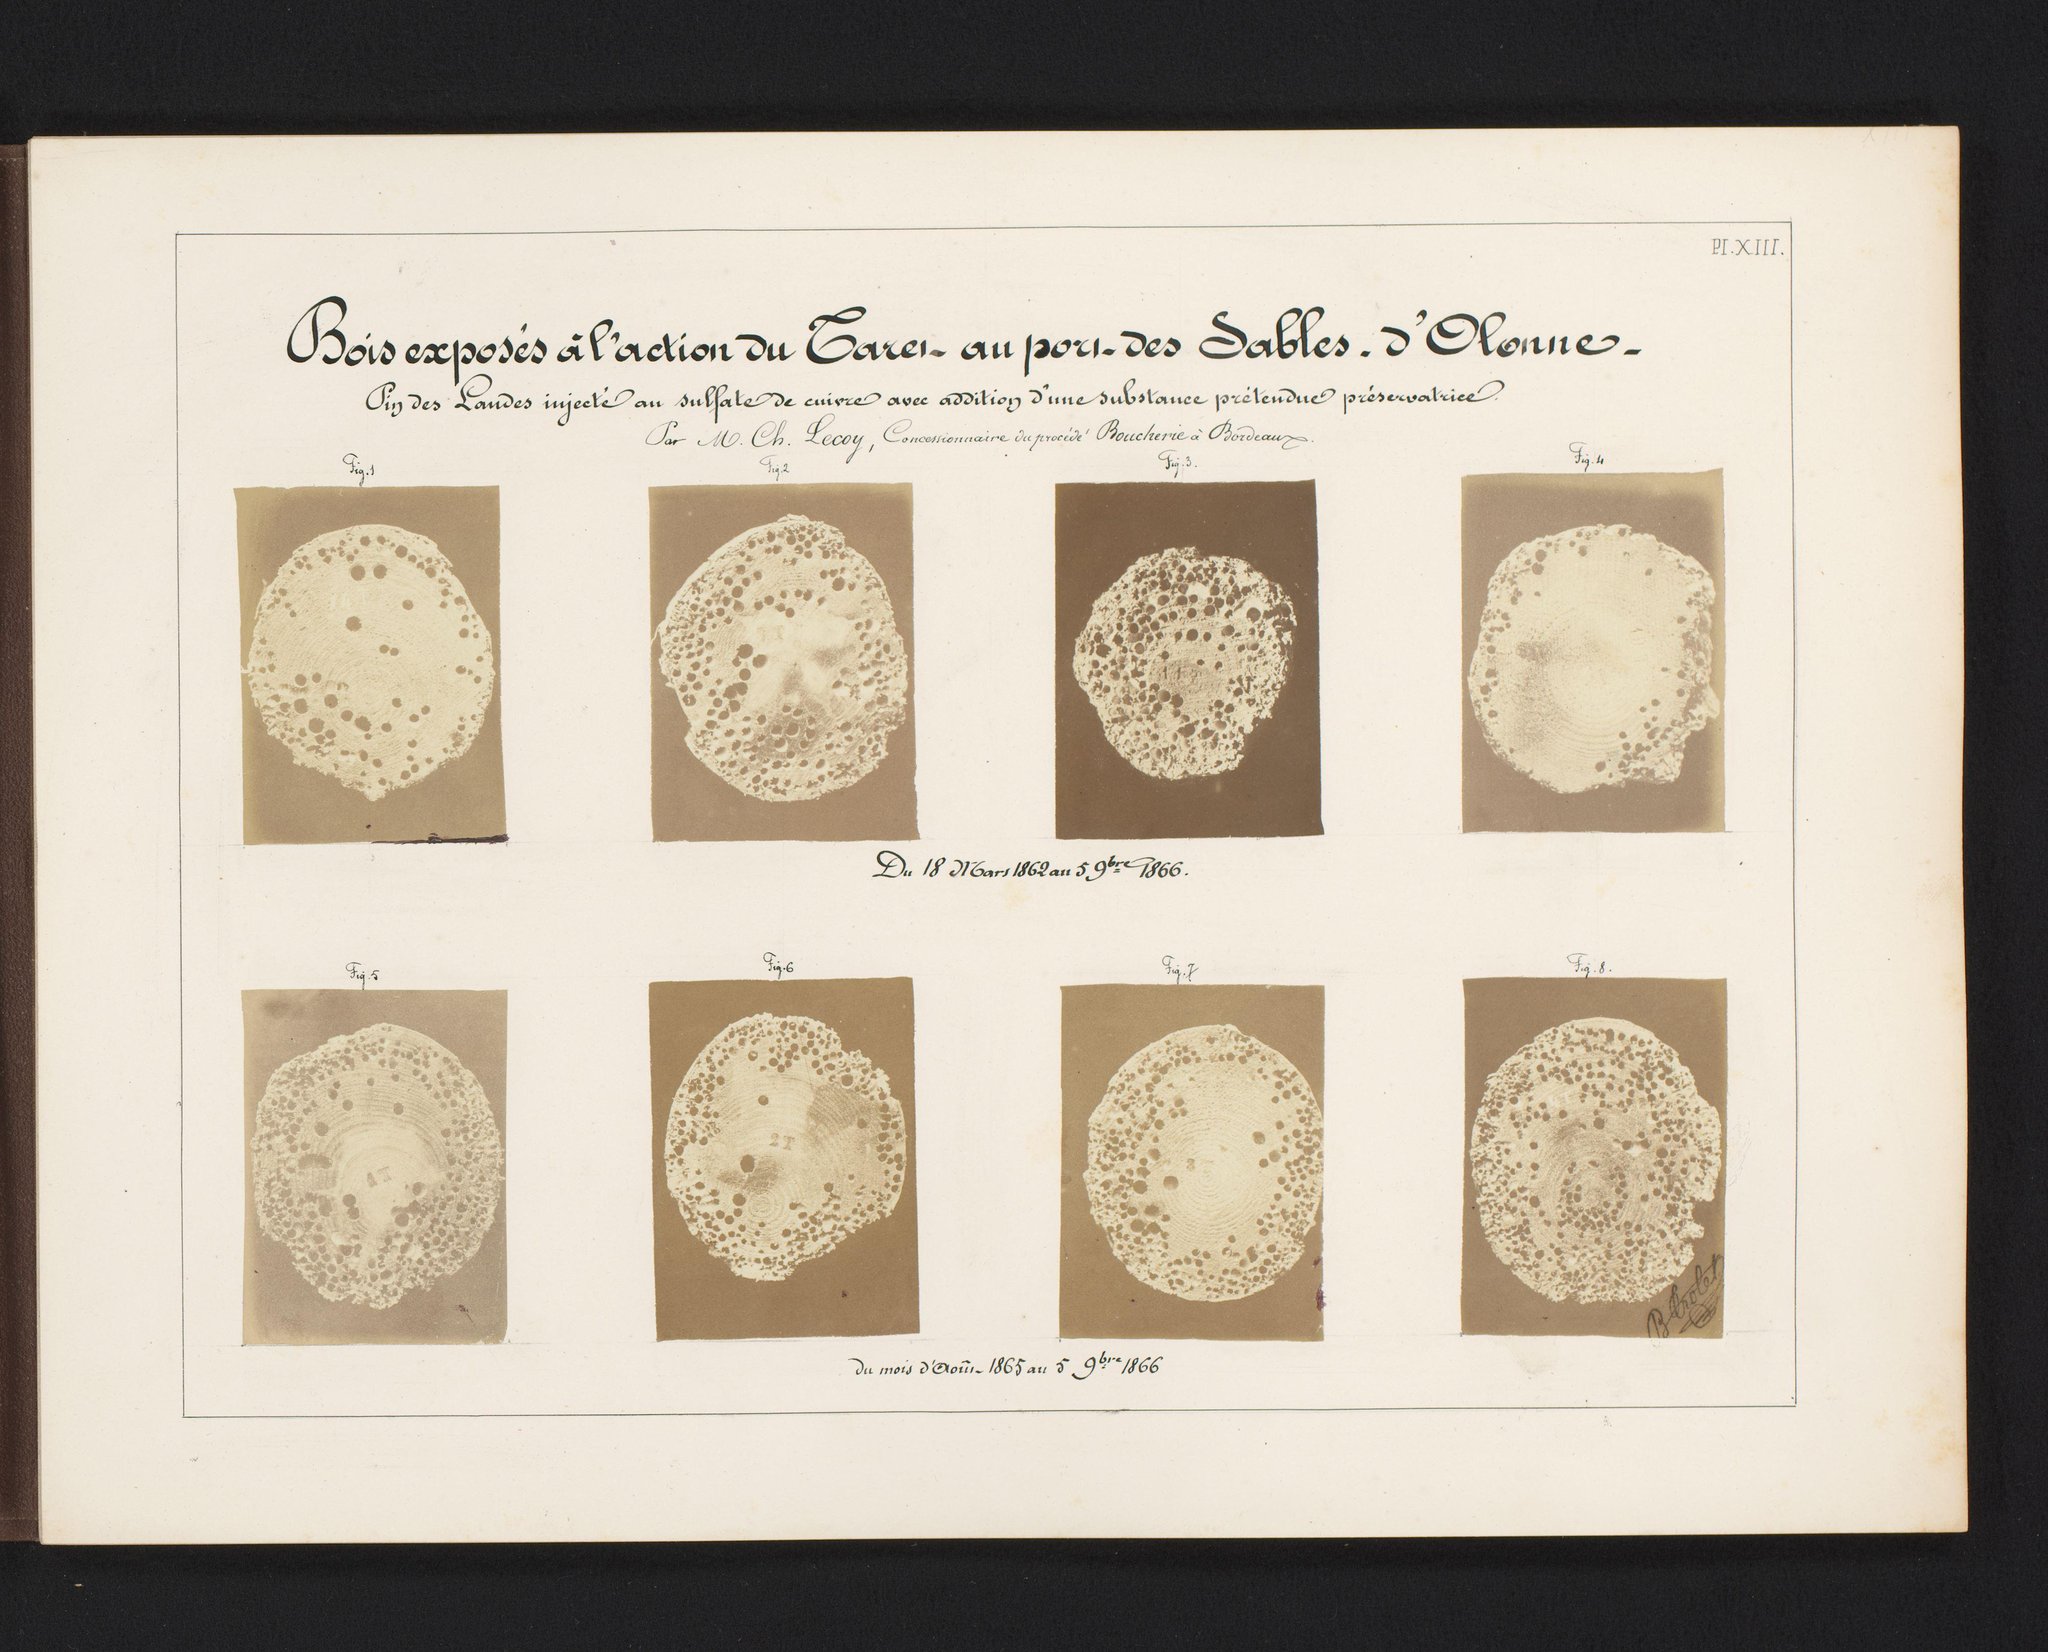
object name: photograph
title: Bois exposés à l'action du Taret au port des Sables-d'Olonne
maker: b. crolet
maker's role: fotograaf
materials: cardboard, photographic support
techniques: albumen print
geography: france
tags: worms, wood, timber ~ building material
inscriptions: annotation: ‘Pin des Landes injecté au sulfate de cuivre avec addition d'une substance prétendue préservatrice/ (...) 5 9bre 1866’, signature: ‘B. Crolet’, number: ‘Pl. XIII.’